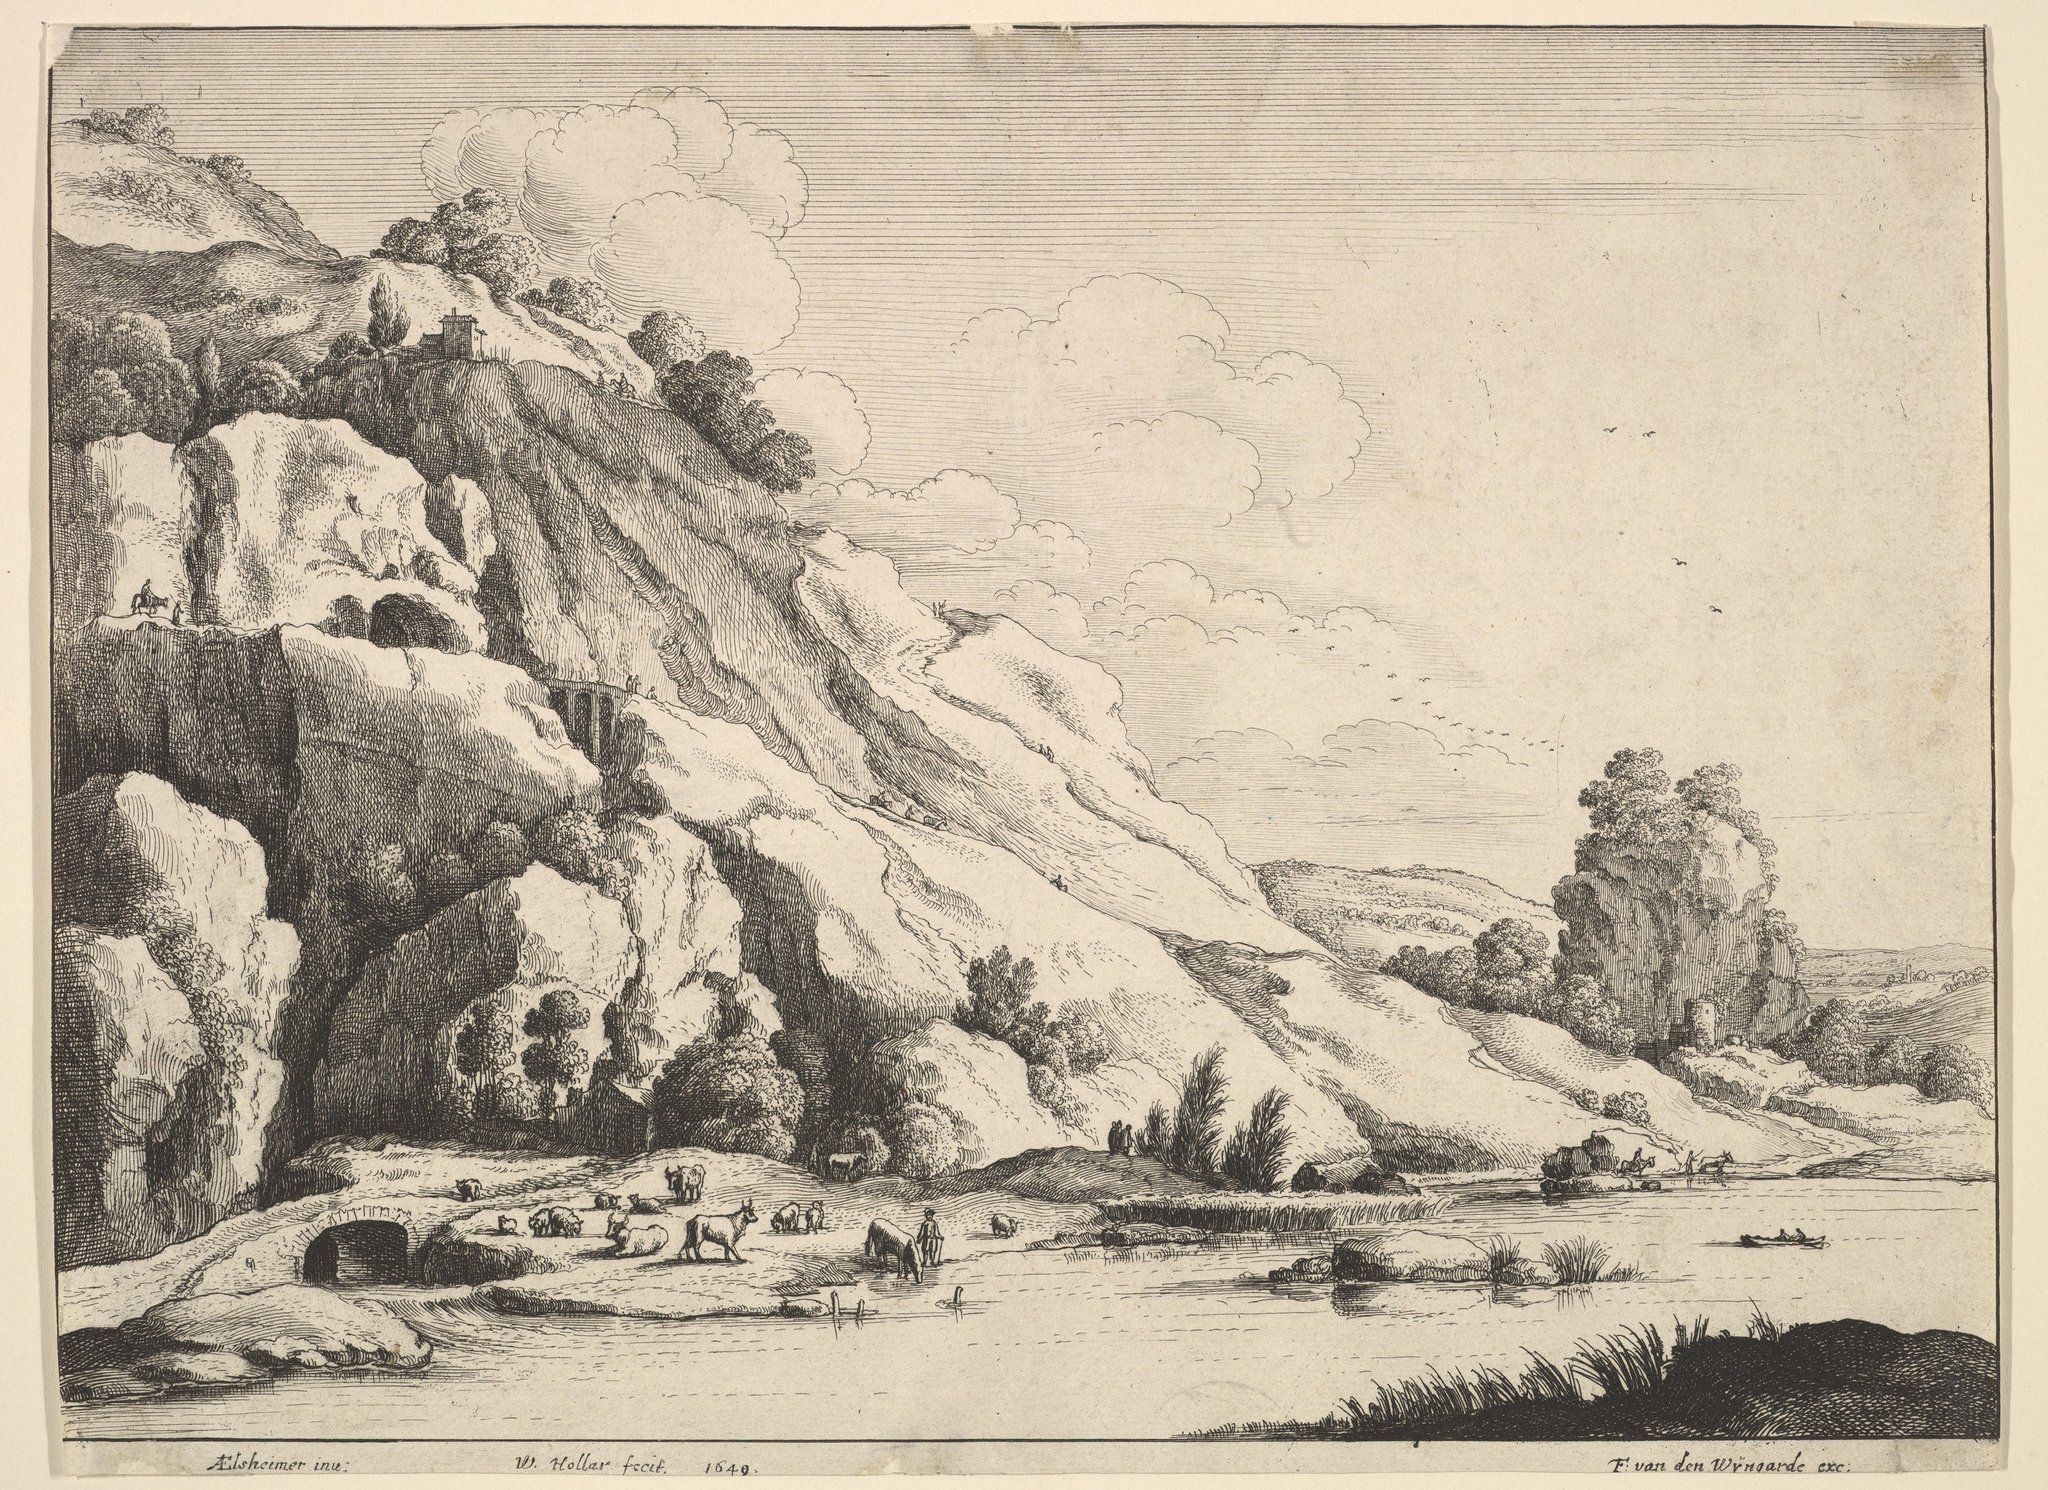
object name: print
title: The Stone Bridge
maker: wenceslaus hollar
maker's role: artist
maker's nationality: bohemian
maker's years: 1607-1677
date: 1649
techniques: etching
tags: bridges,hills,landscapes